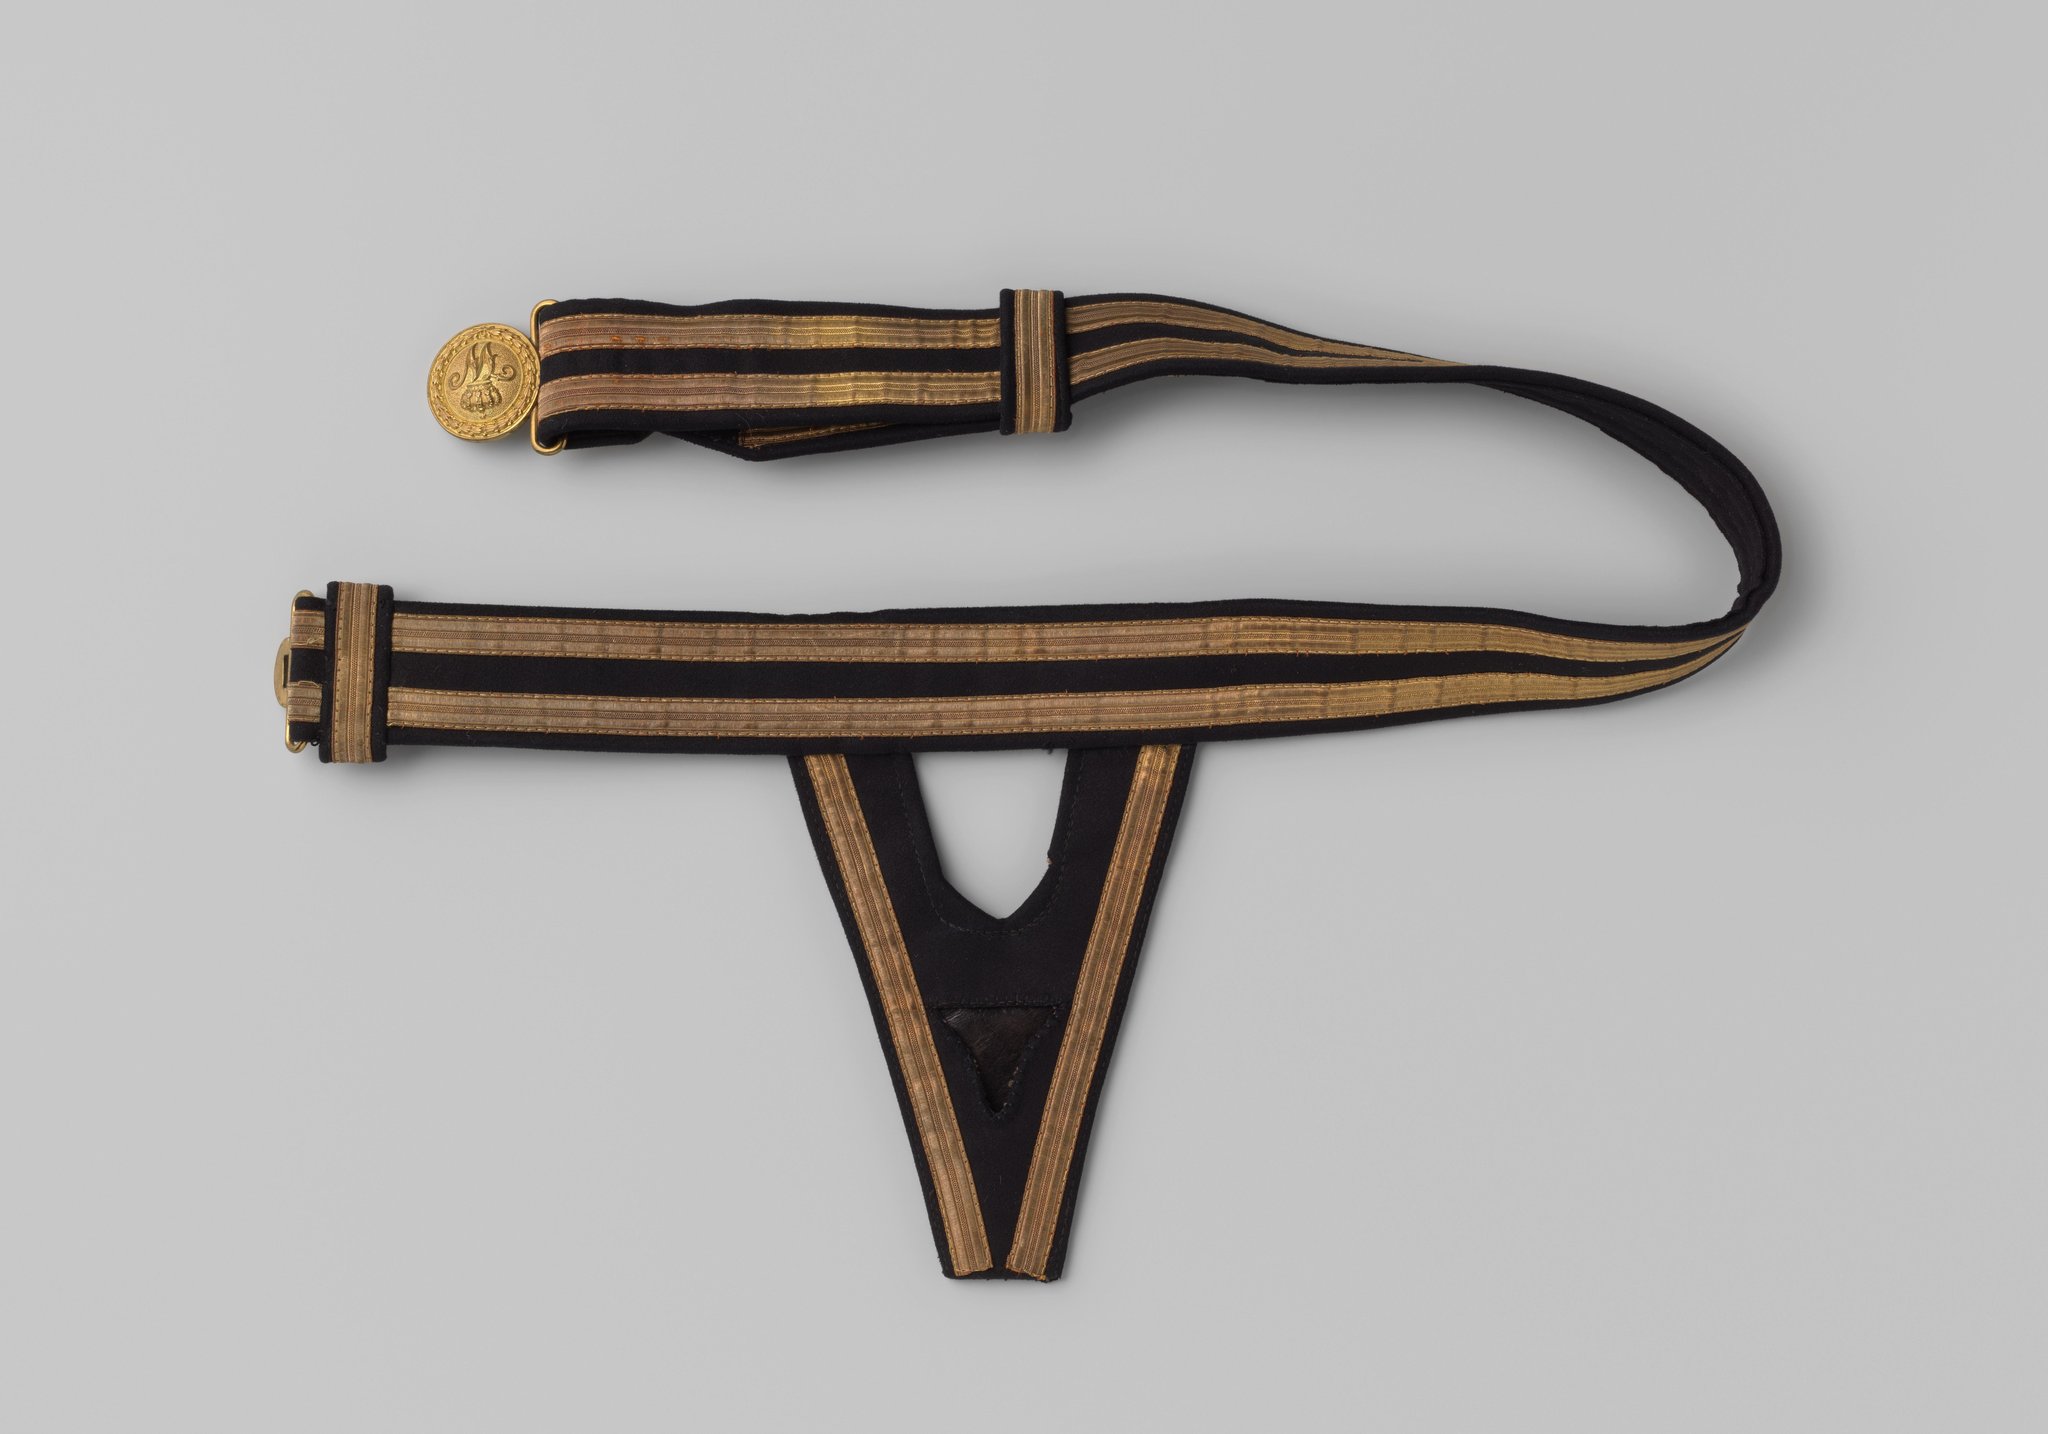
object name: degendrager, degenhanger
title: Degendrager van de jas van ambassadeur A.H.J. Lovink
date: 1948-1950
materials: textile, leather, metal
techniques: sewing, weave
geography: the hague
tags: ambassadeur, hoge vertegenwoordiger van de kroon, antonius hermanus johannes lovink, ottawa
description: Zwarte lakense ceintuur of degendrager, gesloten met goudkleurige metalen gesp waarop een kroonmet een W eronder. Aan de ceintuur hangt een driehoekige zak (om de degen in te hangen). Ceintuur versierd met goudband. Behorend bij ambtskostuum van ambassadeur A.H.J. Lovink.